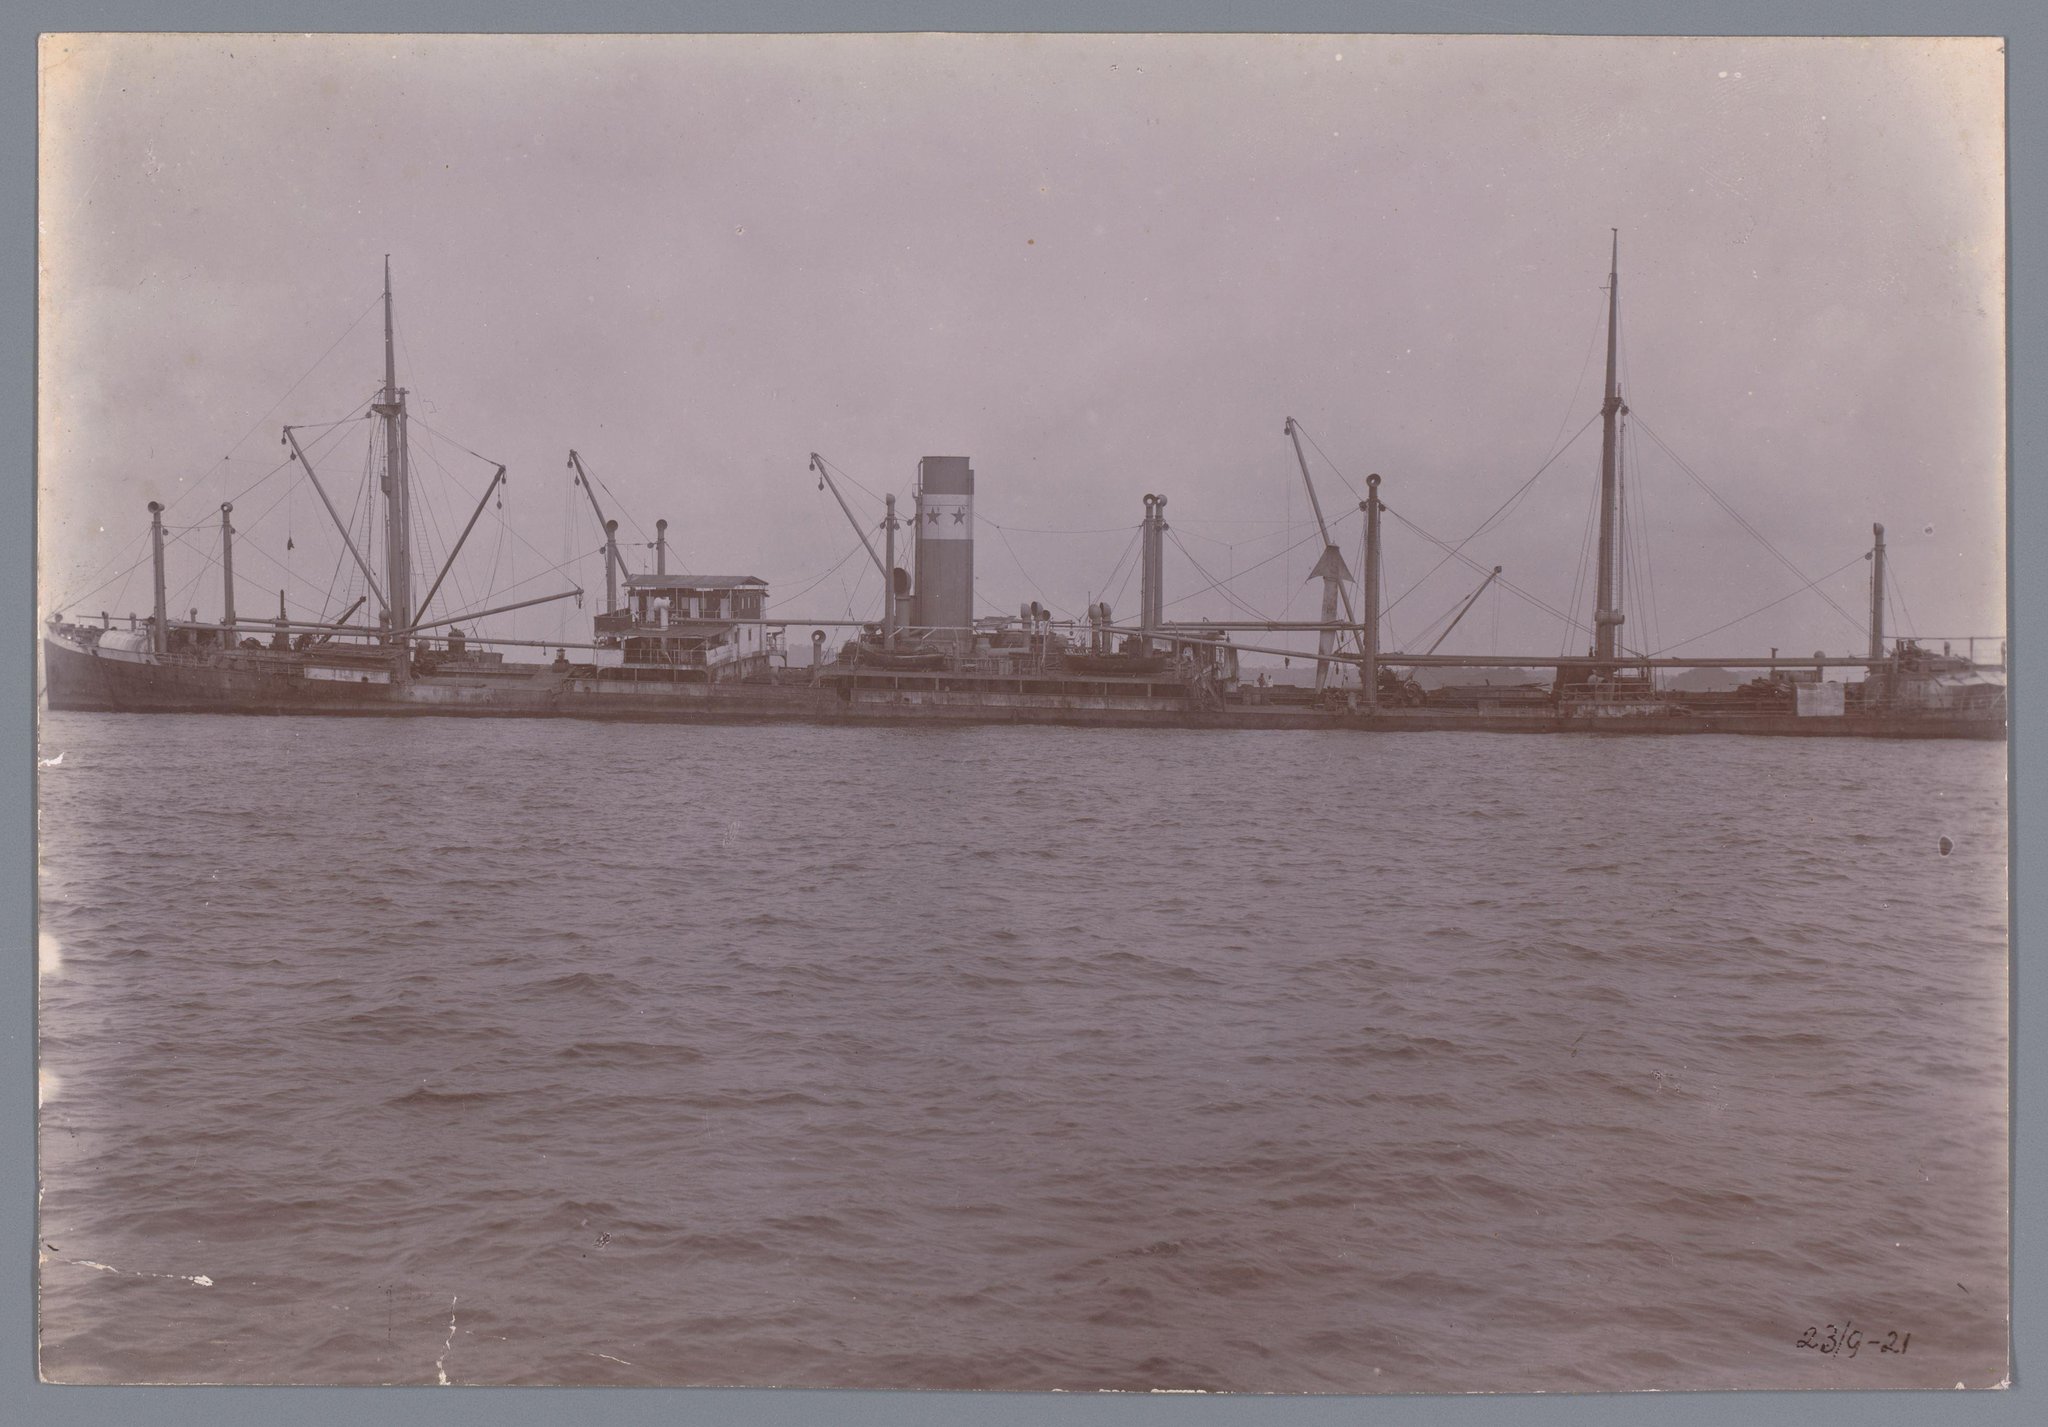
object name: photograph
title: Oceaanhaven Belawan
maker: Anonymous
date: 1921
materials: photographic support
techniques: gelatin silver print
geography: singapore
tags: steamsailer, singapore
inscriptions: date: ‘23/9-21’, inscription: ‘No. 71 / Opname van S.S. Altenburg te Singapore’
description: Het schip S.S. Altenburg in Singapore. Genummerd: 71. Onderdeel van de groep van losse foto's over de aanleg van de haven Belawan aan de kust voor Medan, Sumatra 1921-1922.